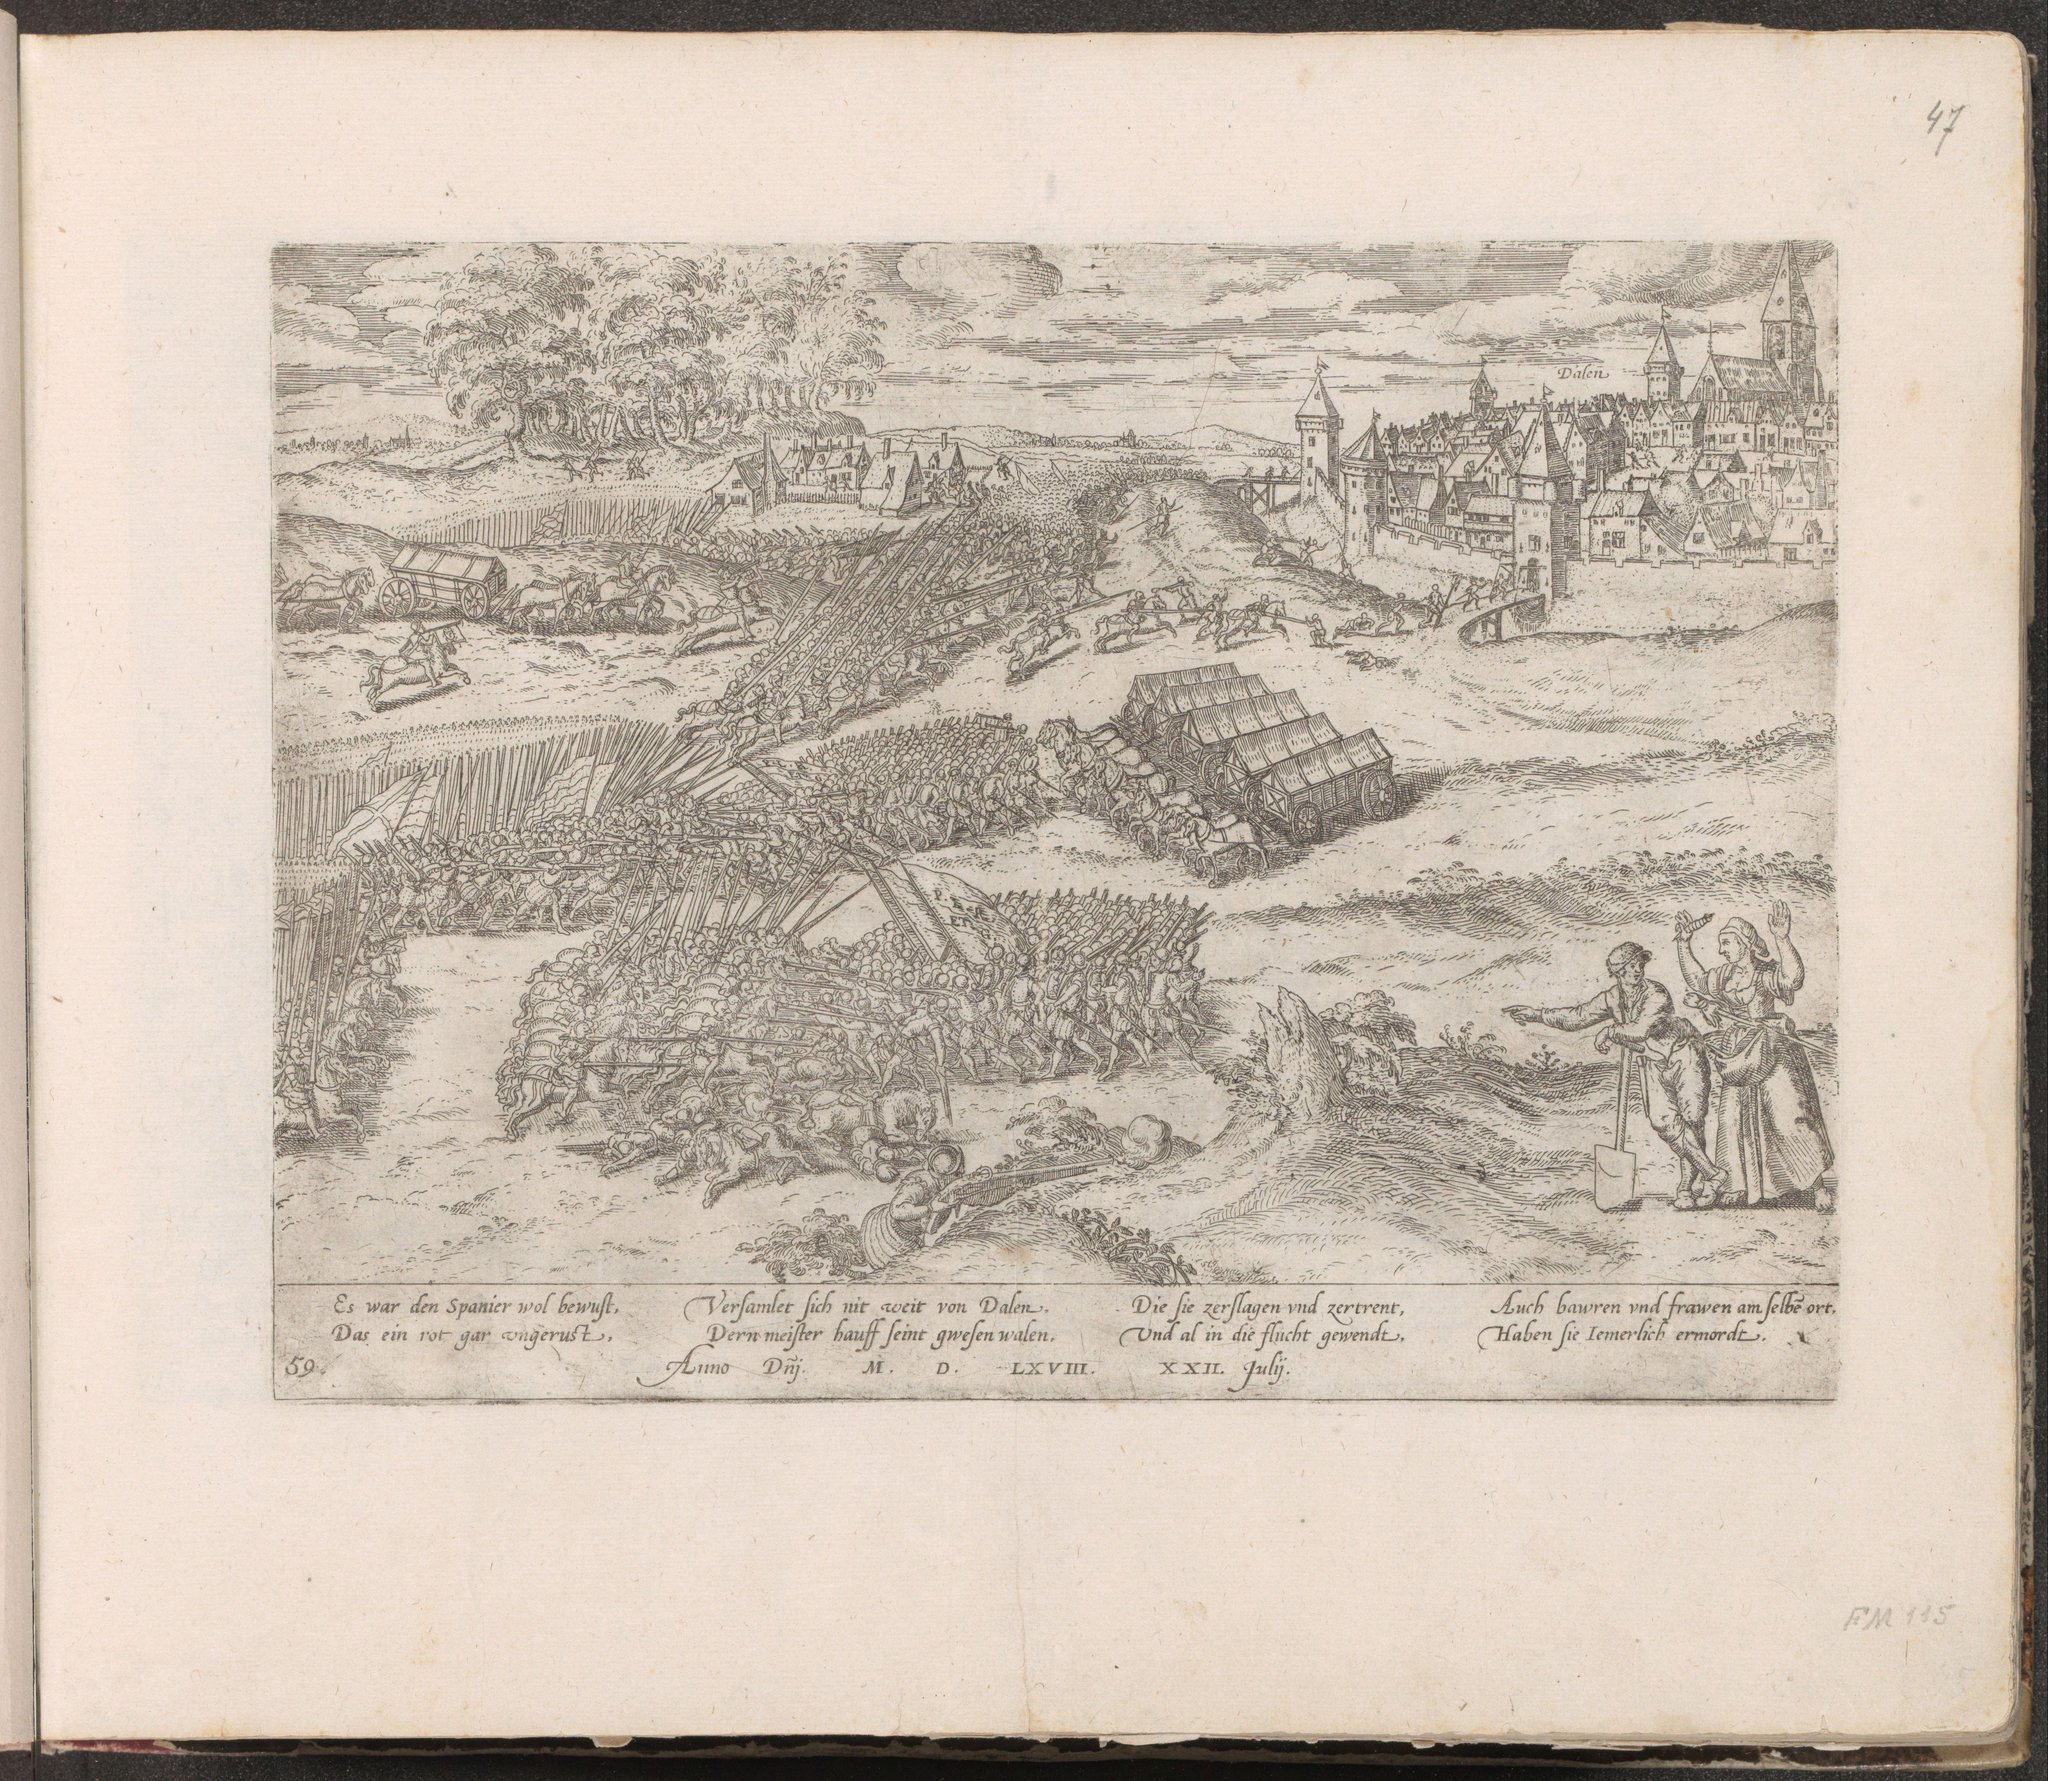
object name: print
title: Serie 5: Nederlandse Gebeurtenissen, 1566-1570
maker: frans hogenberg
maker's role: print maker, publisher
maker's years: 1538-1590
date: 1568-1572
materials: paper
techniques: etching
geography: cologne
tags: battle (+ land forces)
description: Slag bij Dahlen of Daalheim. Op de prent vermeld als 22 juli 1568, in werkelijkheid op 25 april. Op de voorgrond worden twee landlieden die kijken naar de veldslag onder vuur genomen. In de verte de stad Dahlen. Met onderschrift van 8 regels in het Duits. Linksonder genummerd: 59. De prent maakt deel uit van een album.